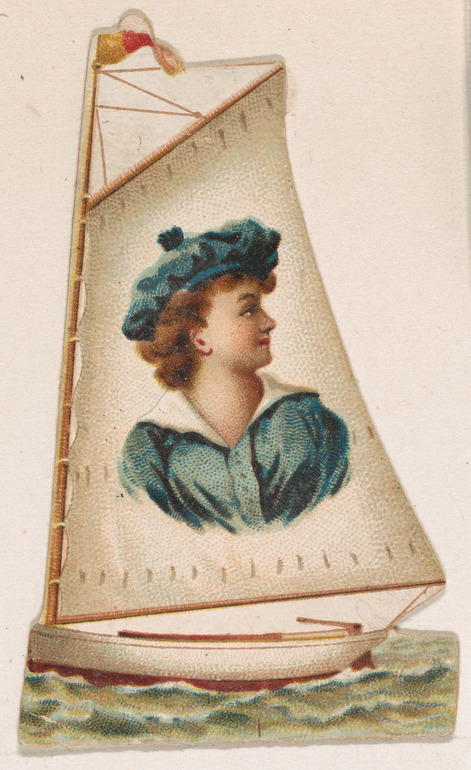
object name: print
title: Sailboat, from the Novelties series (N228, Type 3) issued by Kinney Bros.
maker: kinney brothers tobacco company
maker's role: publisher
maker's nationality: american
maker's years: 1869-2011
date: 1889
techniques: color lithograph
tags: profiles,women,boats